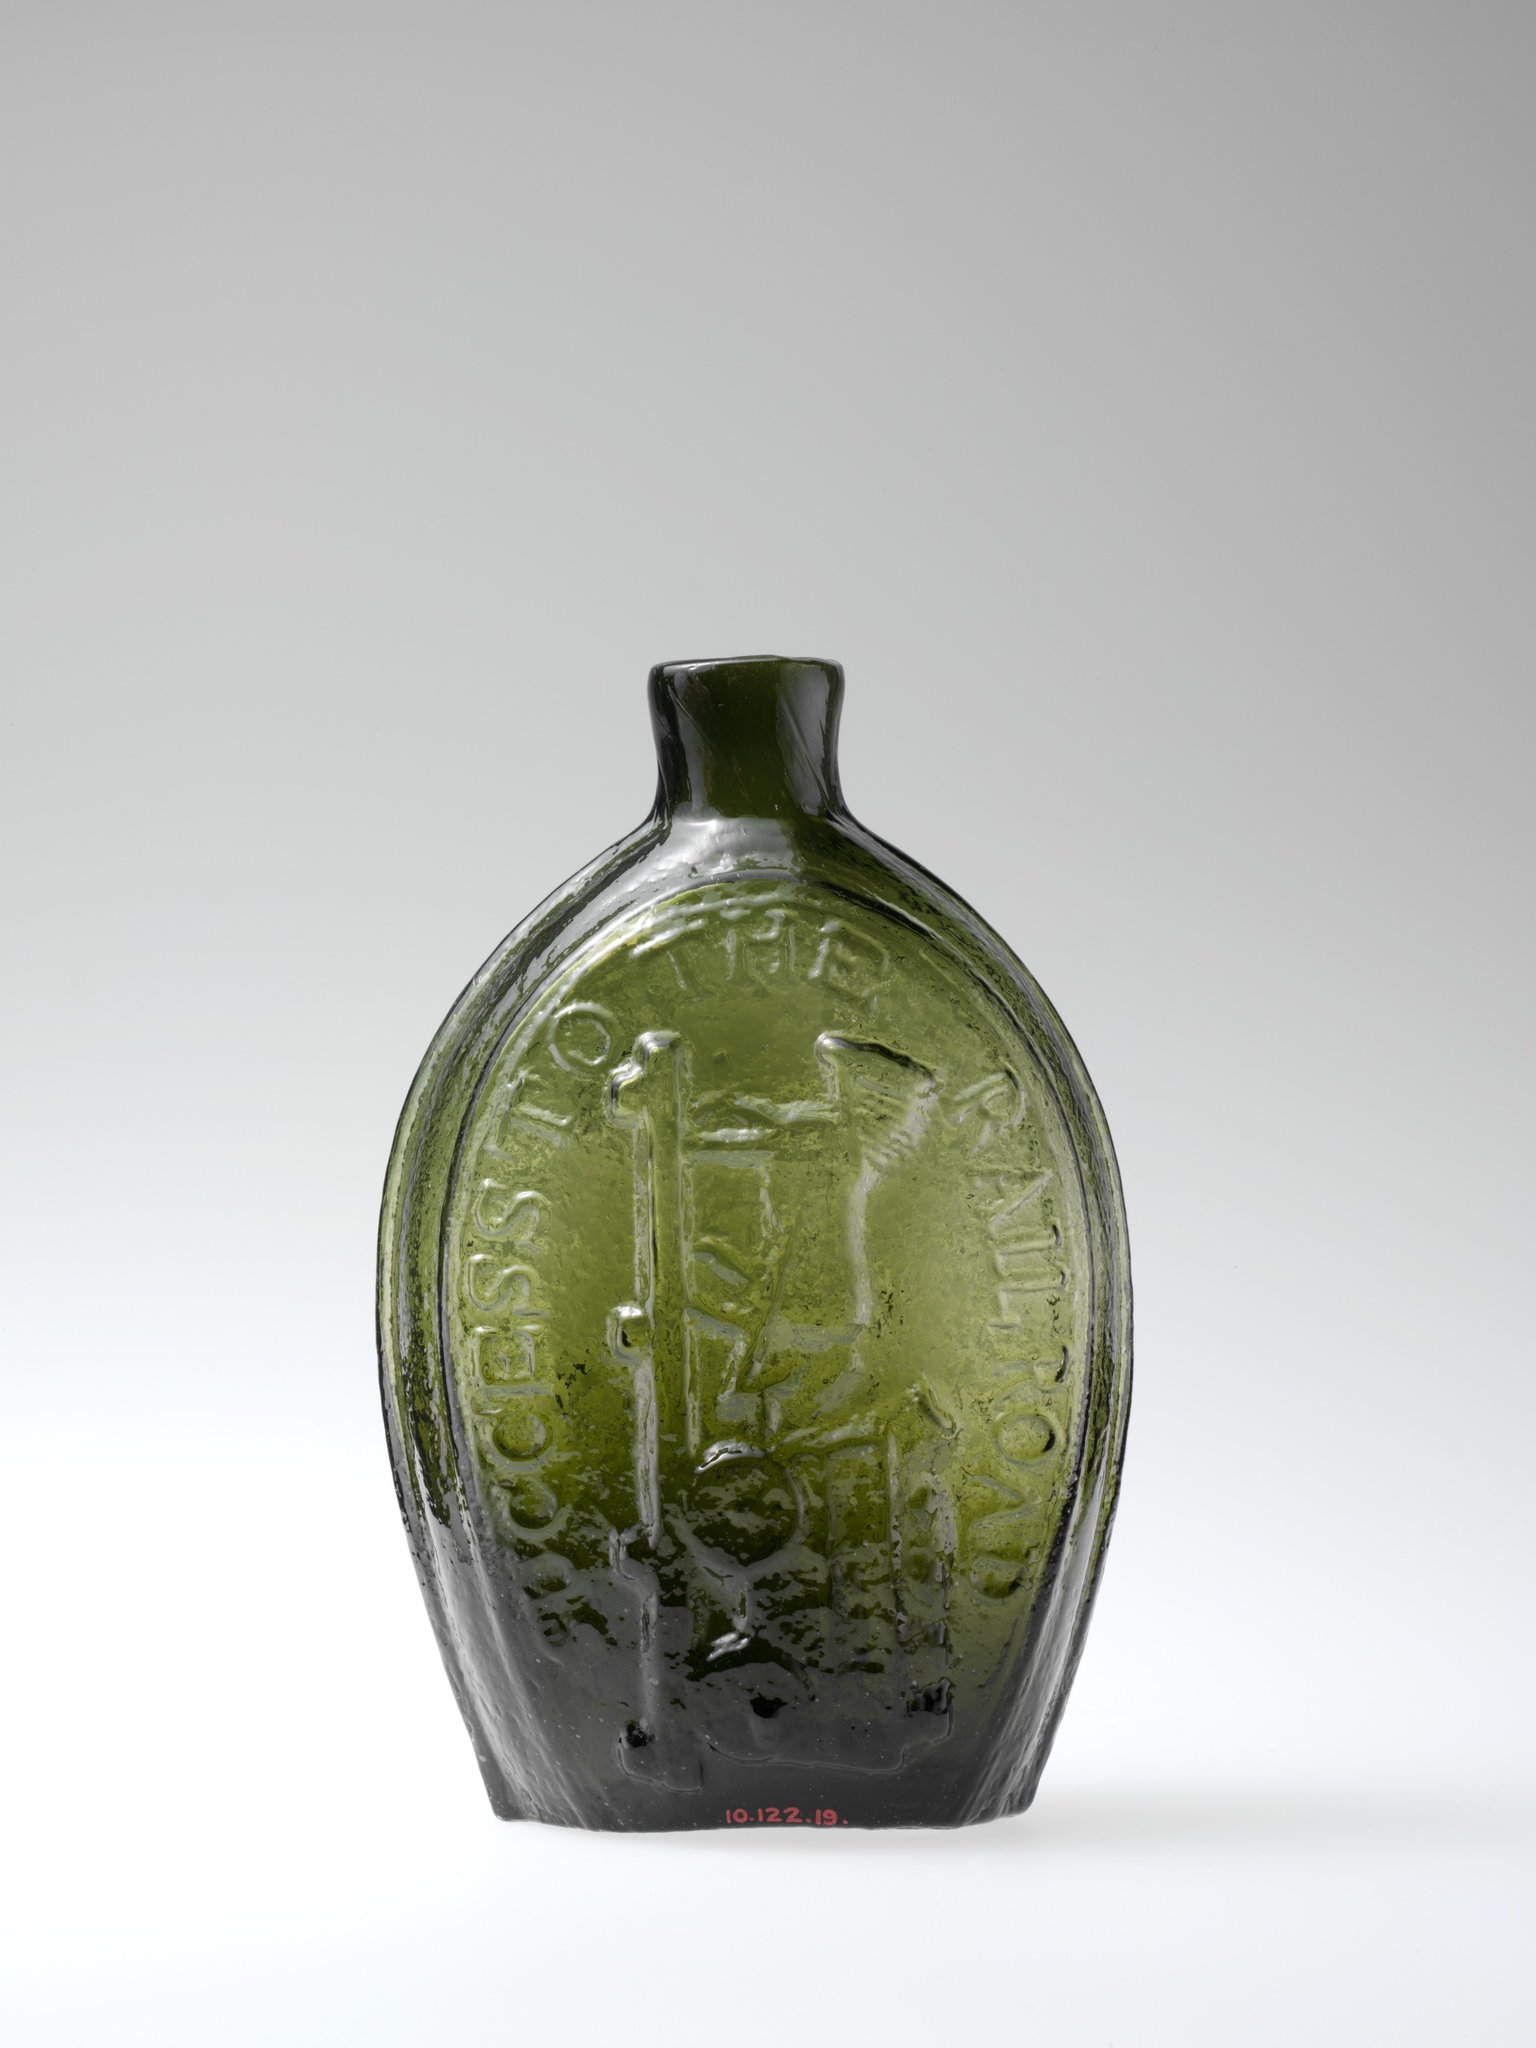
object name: flask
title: Figured flask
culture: american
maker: keene glass works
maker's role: maker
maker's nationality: american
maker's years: 1815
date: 1830-1840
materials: glass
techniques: glassblowing, molding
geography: united states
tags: horses,carts